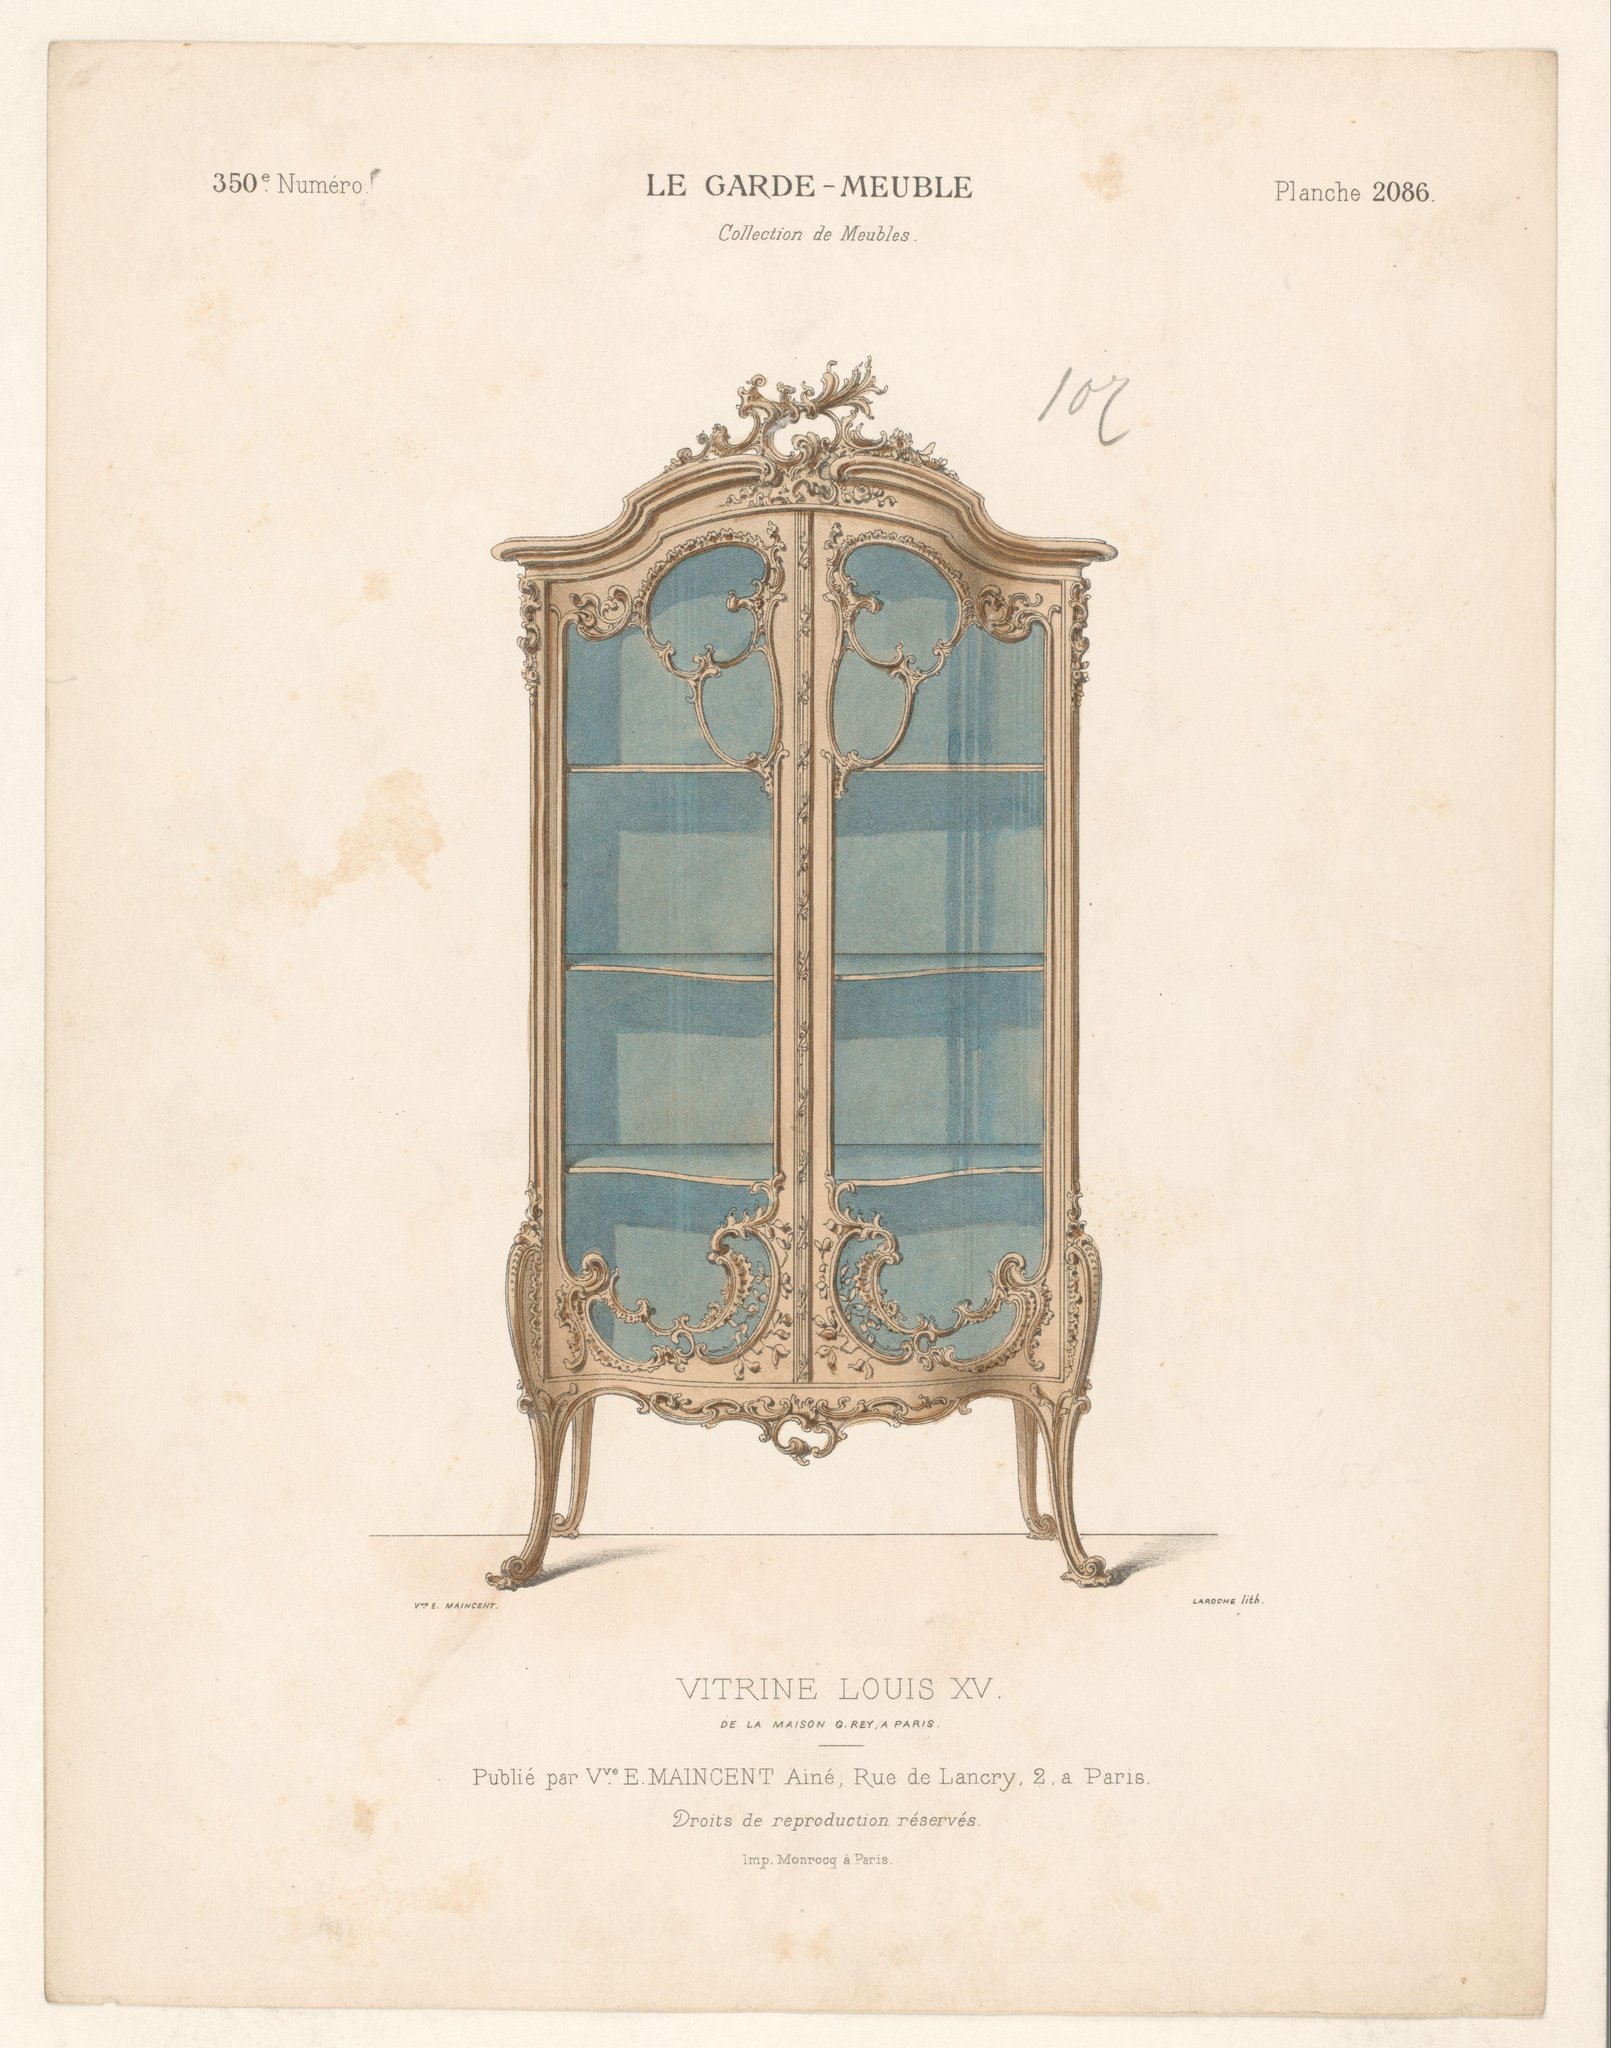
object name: print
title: Vitrine Louis XV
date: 1895-1935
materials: paper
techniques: hand coloring, lithograph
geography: paris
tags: furniture for storage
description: Ieder Livraison in de serie Le Garde-Meuble bevat negen platen: drie 'sièges' (zitmeubels), drie 'meubles' (diverse meubels zoals tafels en kasten) en drie 'tentures' (gordijnen en draperieën).